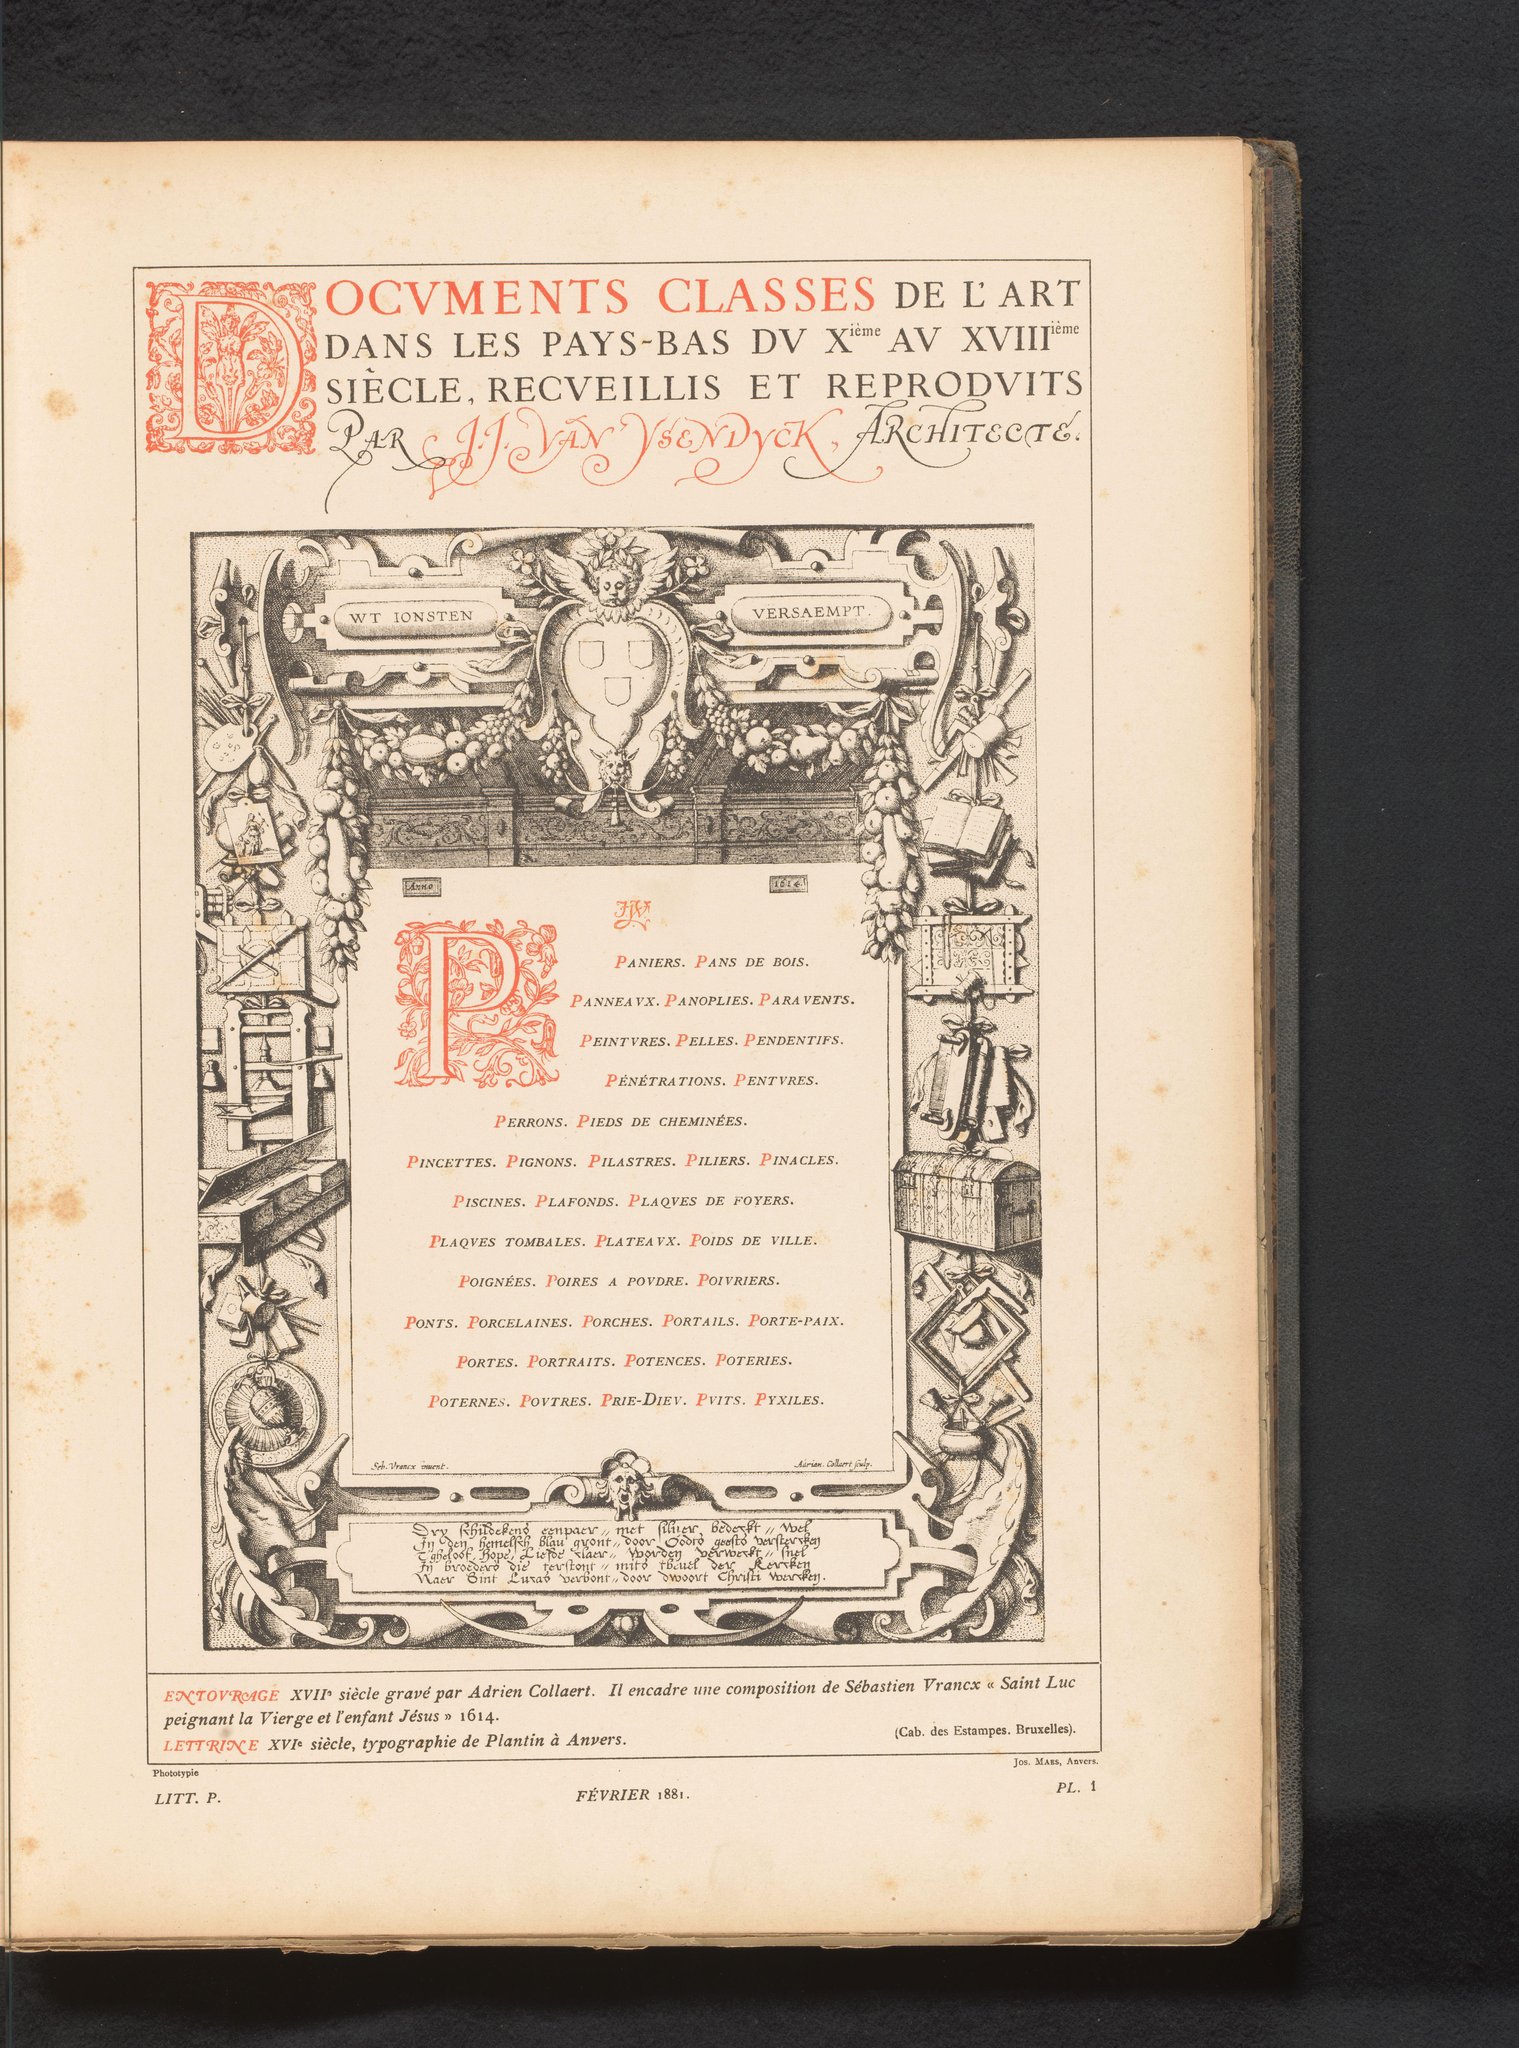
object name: photomechanical print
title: Reproductie van een titelpagina met een omlijsting met schilderspullen door Adriaen Collaert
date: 1876-1881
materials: paper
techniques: photolithography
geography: antwerp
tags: painting (including book-illumination, miniature-painting) (+ materials ~ arts), title-page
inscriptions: monogram: ‘JJvY’, inscription: ‘LITT. P. - PL. 1’, inscription: ‘ENTOURAGE XVIIe siècle (...)’